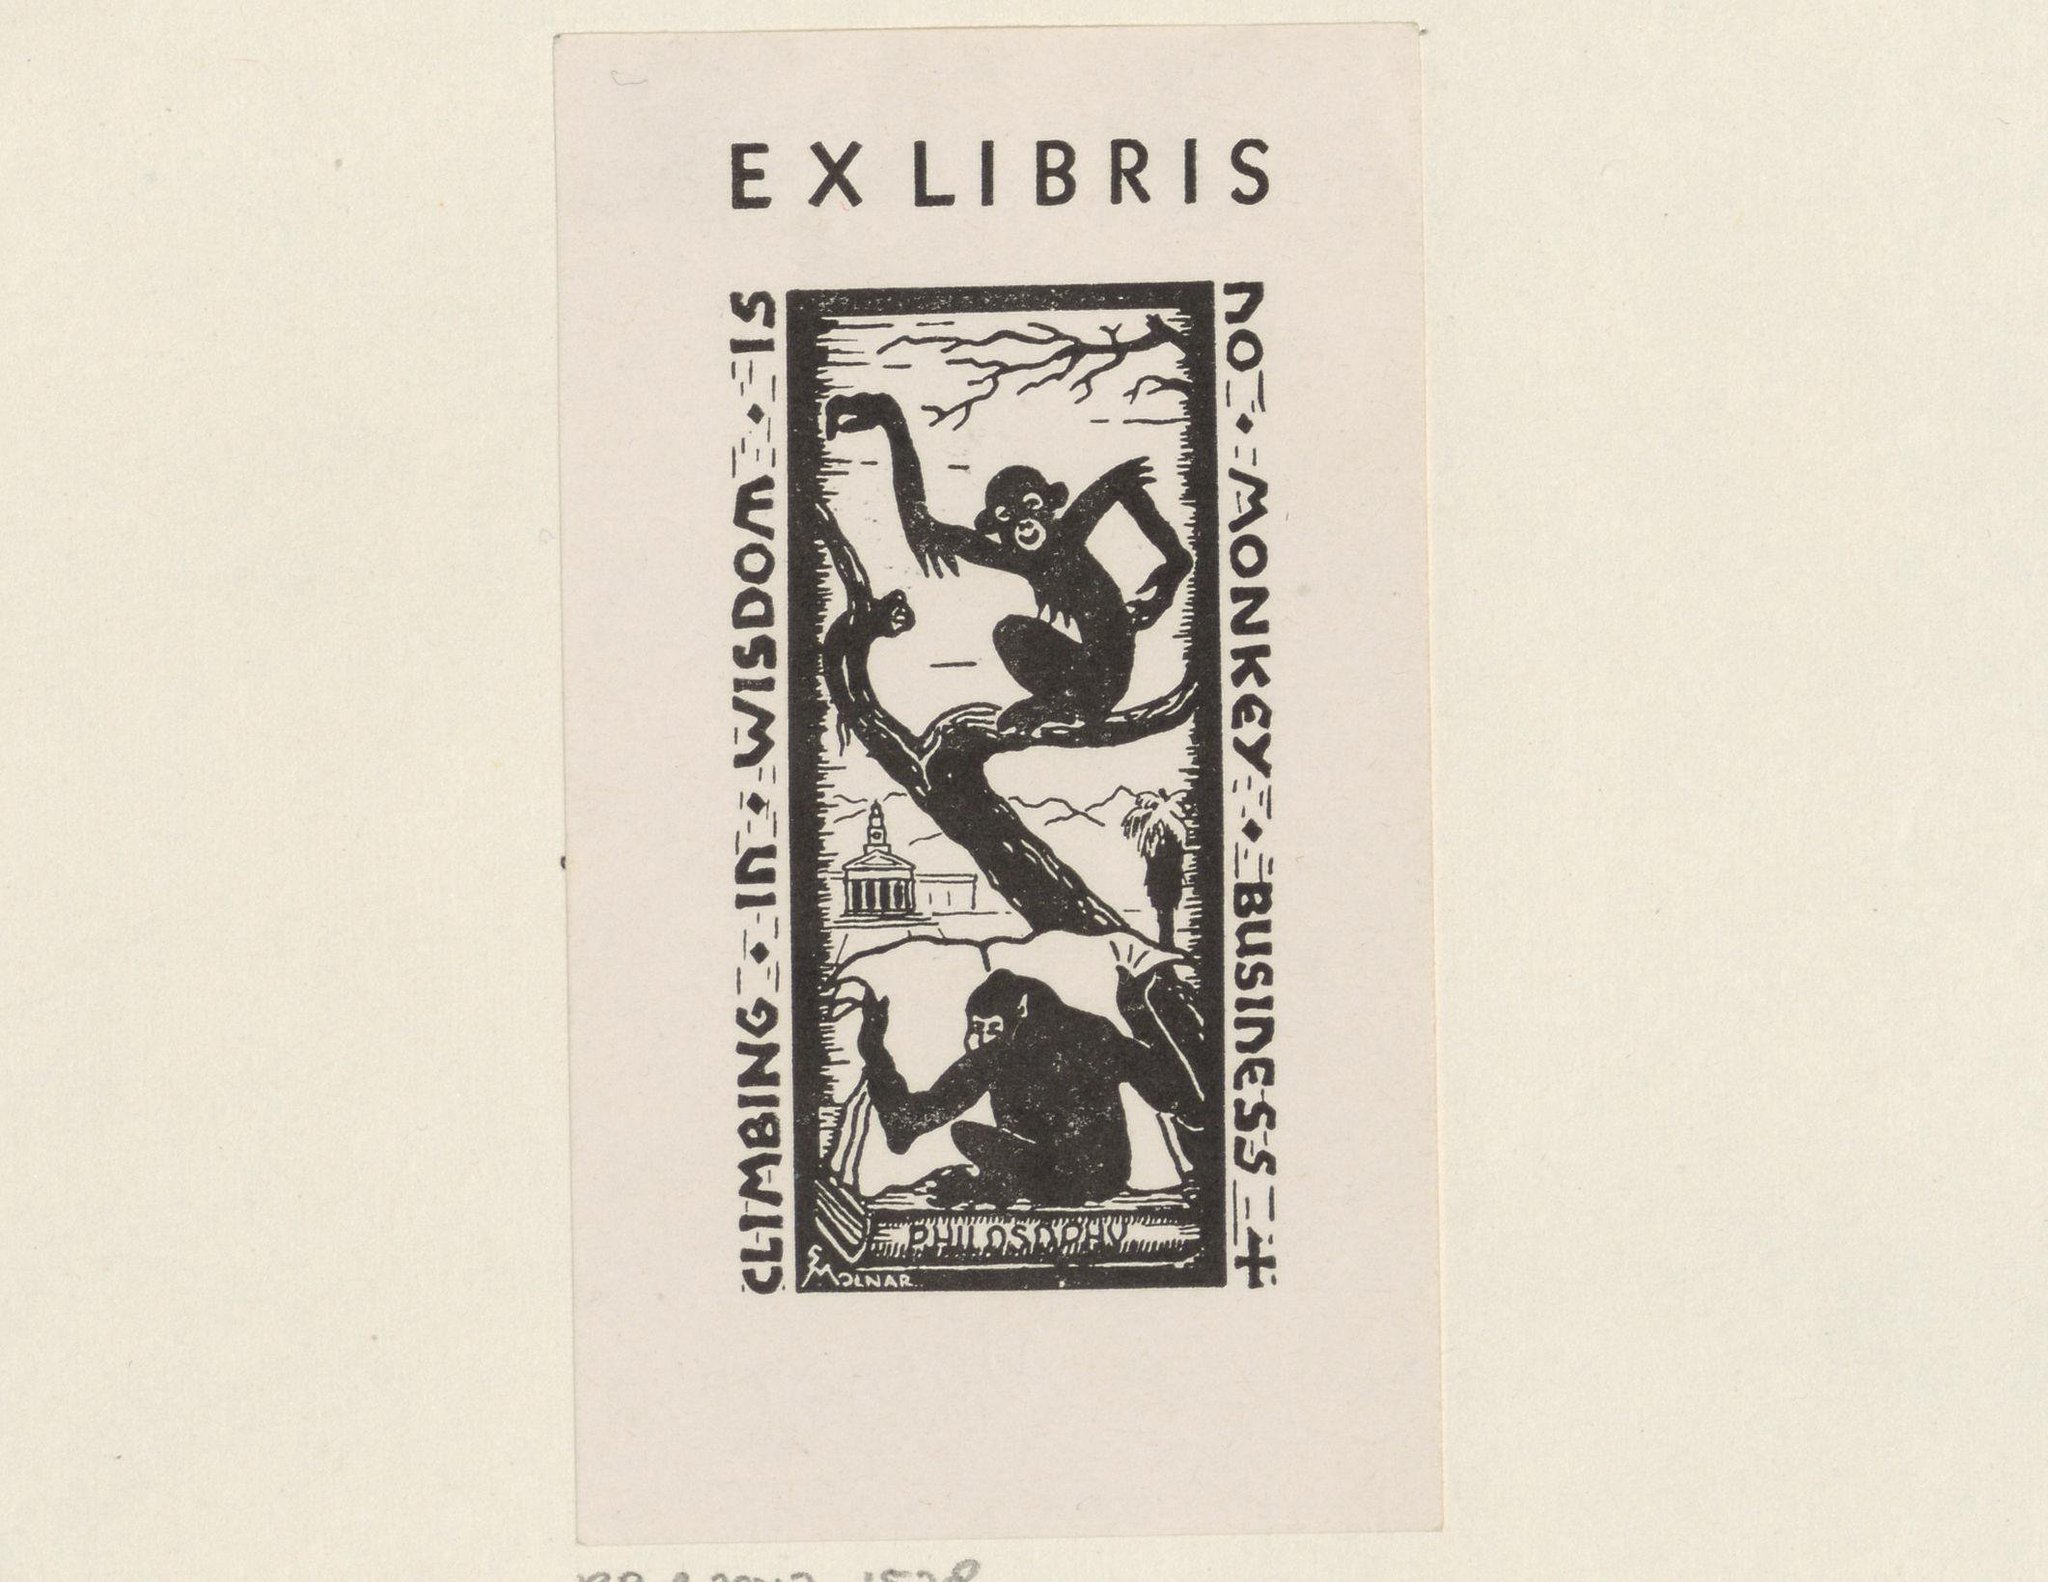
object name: bookplate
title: Climbing in wisdom is no monkey business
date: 1900-1999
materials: paper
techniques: printing block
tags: trees, monkeys, apes